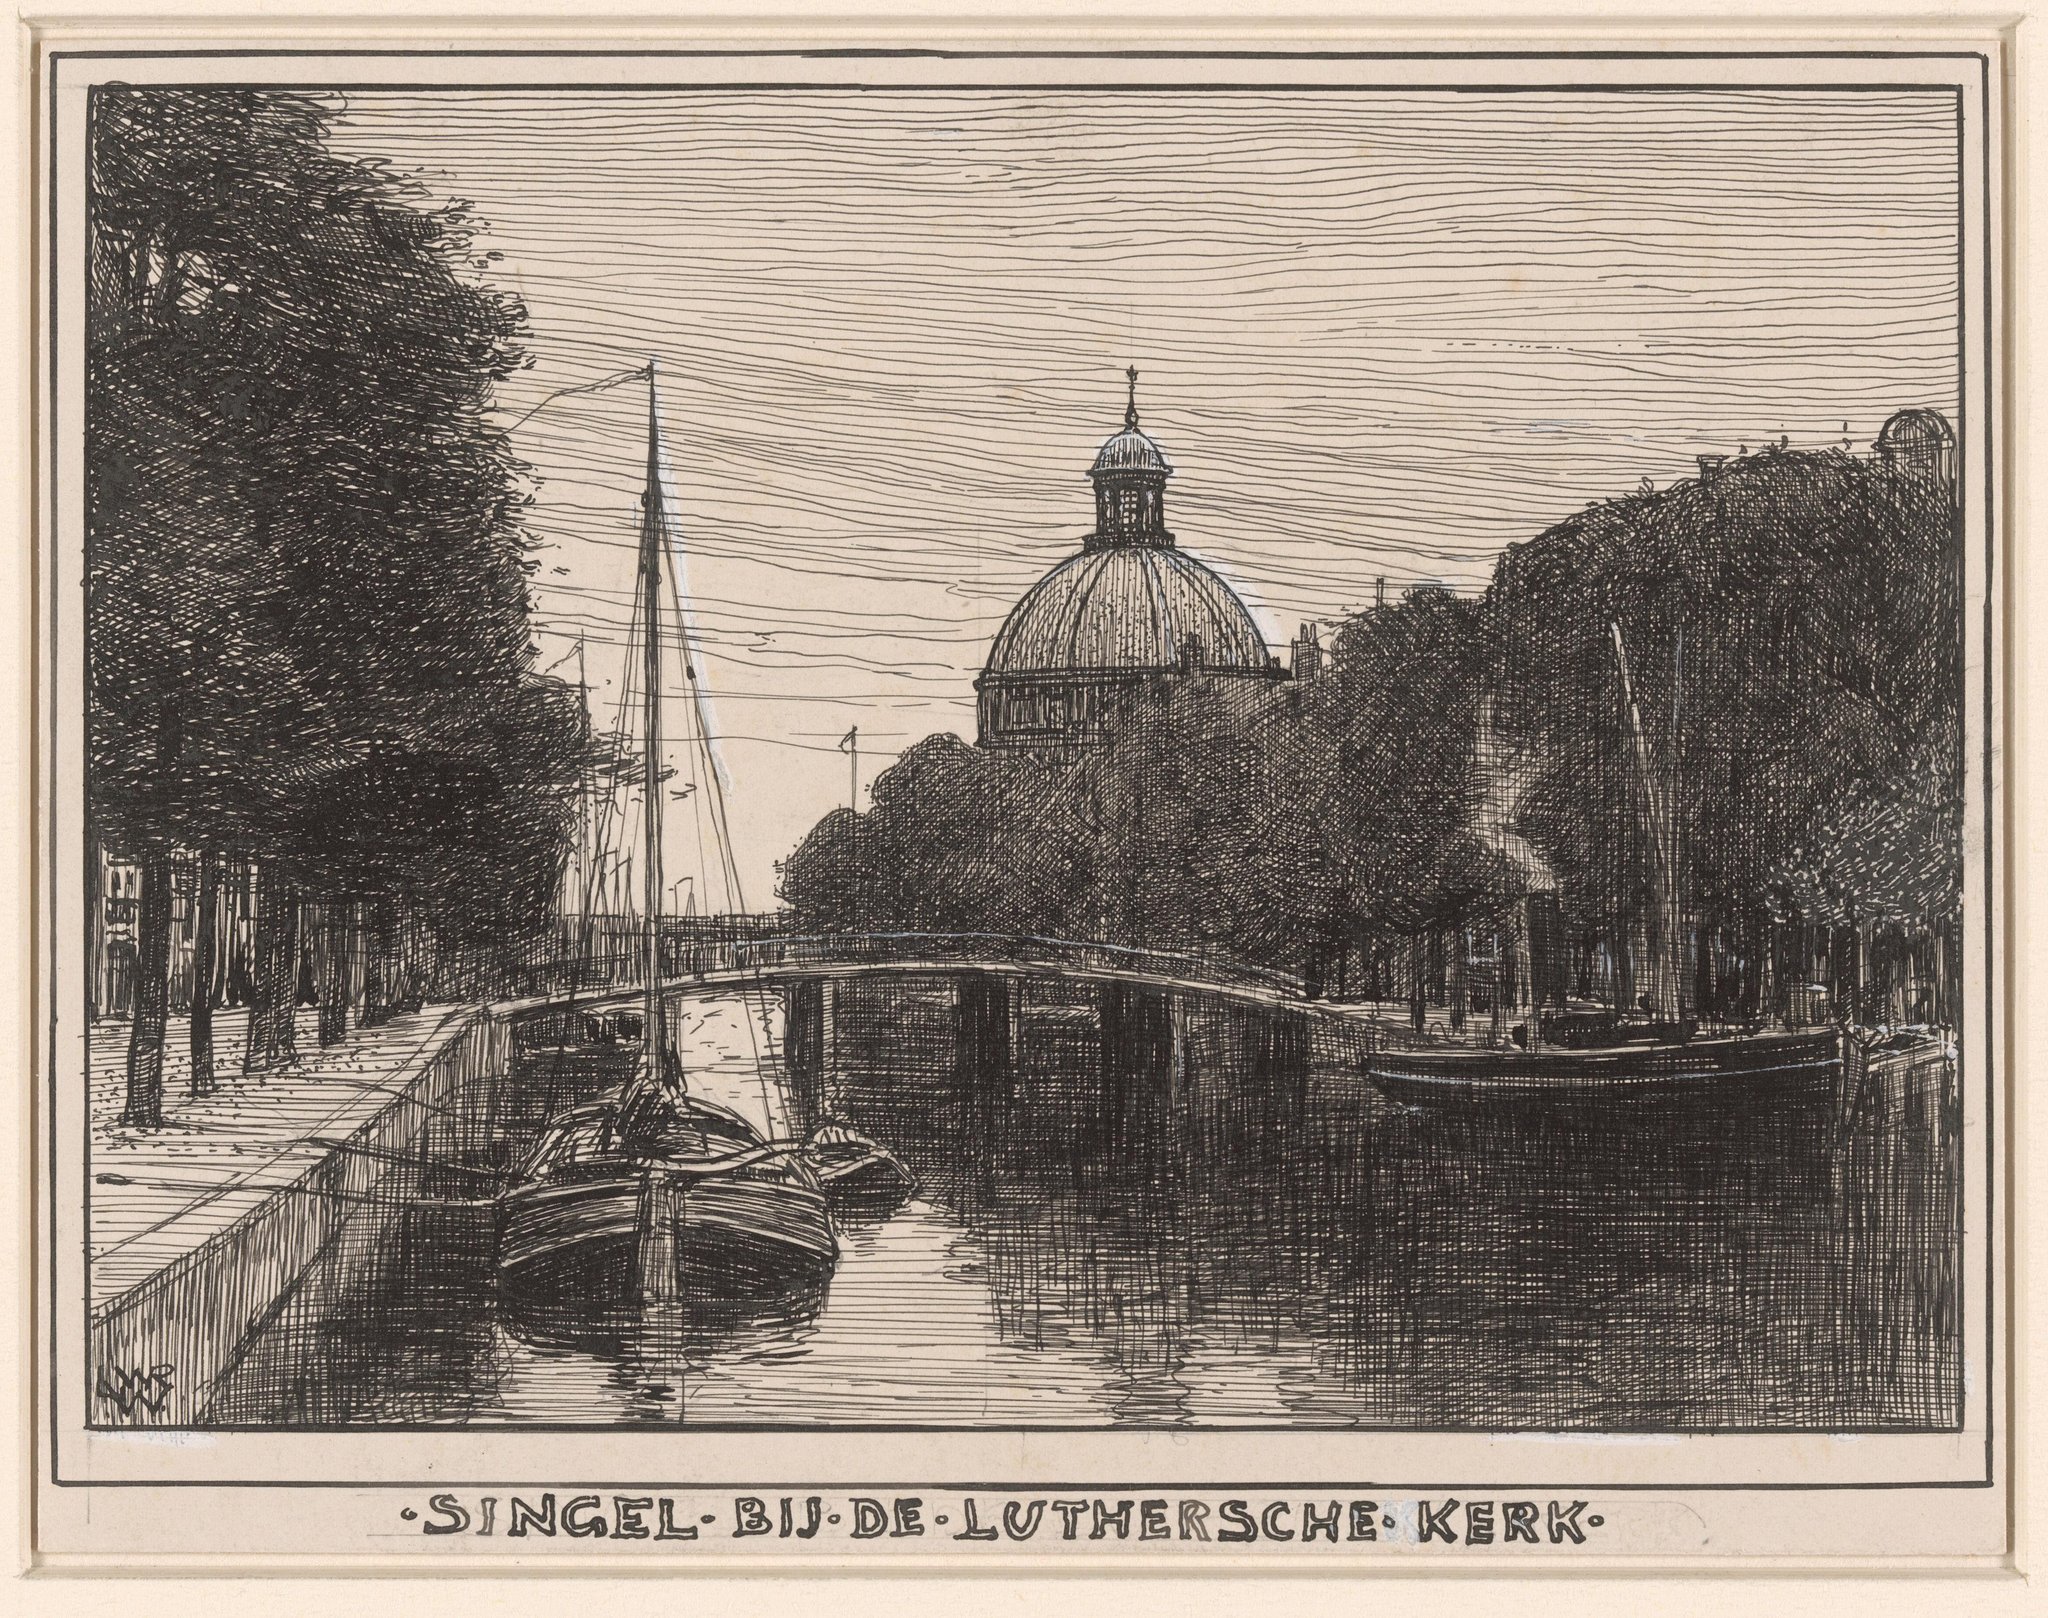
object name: drawing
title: Singel bij de Luthersche kerk te Amsterdam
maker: willem wenckebach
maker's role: designer, draughtsman, painter, print maker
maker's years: 1860-1937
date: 1870-1926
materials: cardboard, paint, ink, pencil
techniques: pen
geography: amsterdam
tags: canals, waters (in city), amsterdam